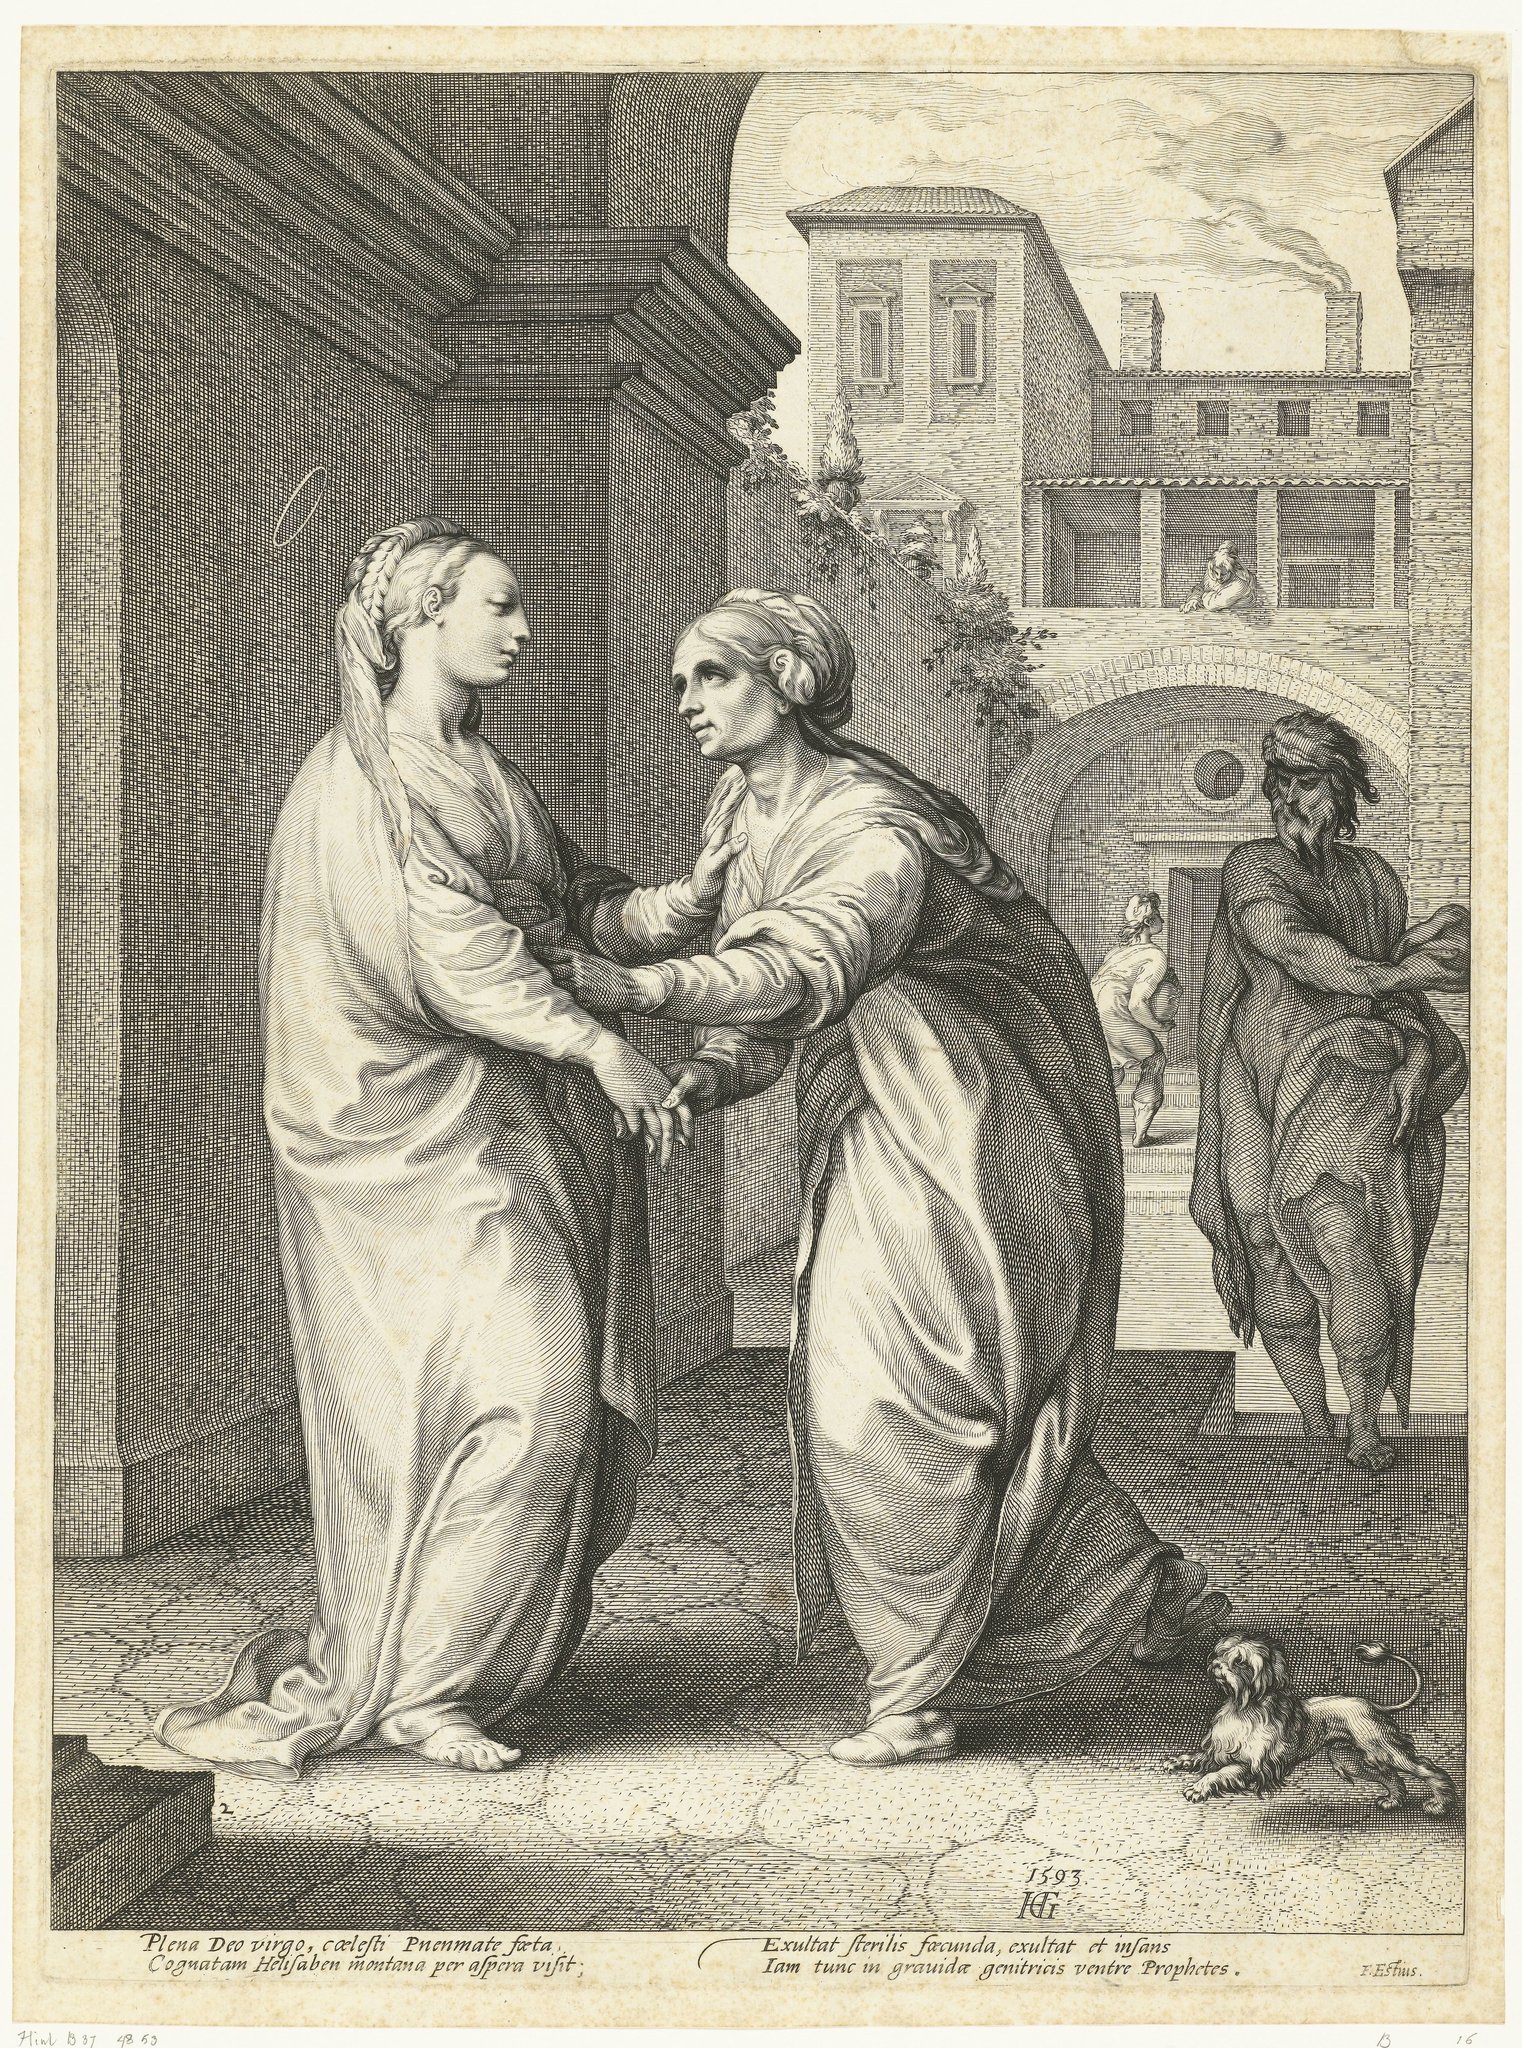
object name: print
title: De visitatie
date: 1593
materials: paper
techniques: engraving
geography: haarlem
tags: visitation (possibly joseph and/or zacharias present) (luke 1:39-56)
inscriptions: collector's mark: Lugt 11, collector's mark: ‘Hinloopen’, collector's mark: Lugt 10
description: Maria en Elizabeth, beiden net zwanger, ontmoeten elkaar bij een stadspoort. Onder de voorstelling vier Latijnse versregels. Deze prent is onderdeel van een serie van zes prenten met scènes uit het vroege leven van Maria. Die worden de 'Meesterstukken' genoemd, omdat Goltzius er het werk van verschillende illustere voorgangers in heeft nagebootst.